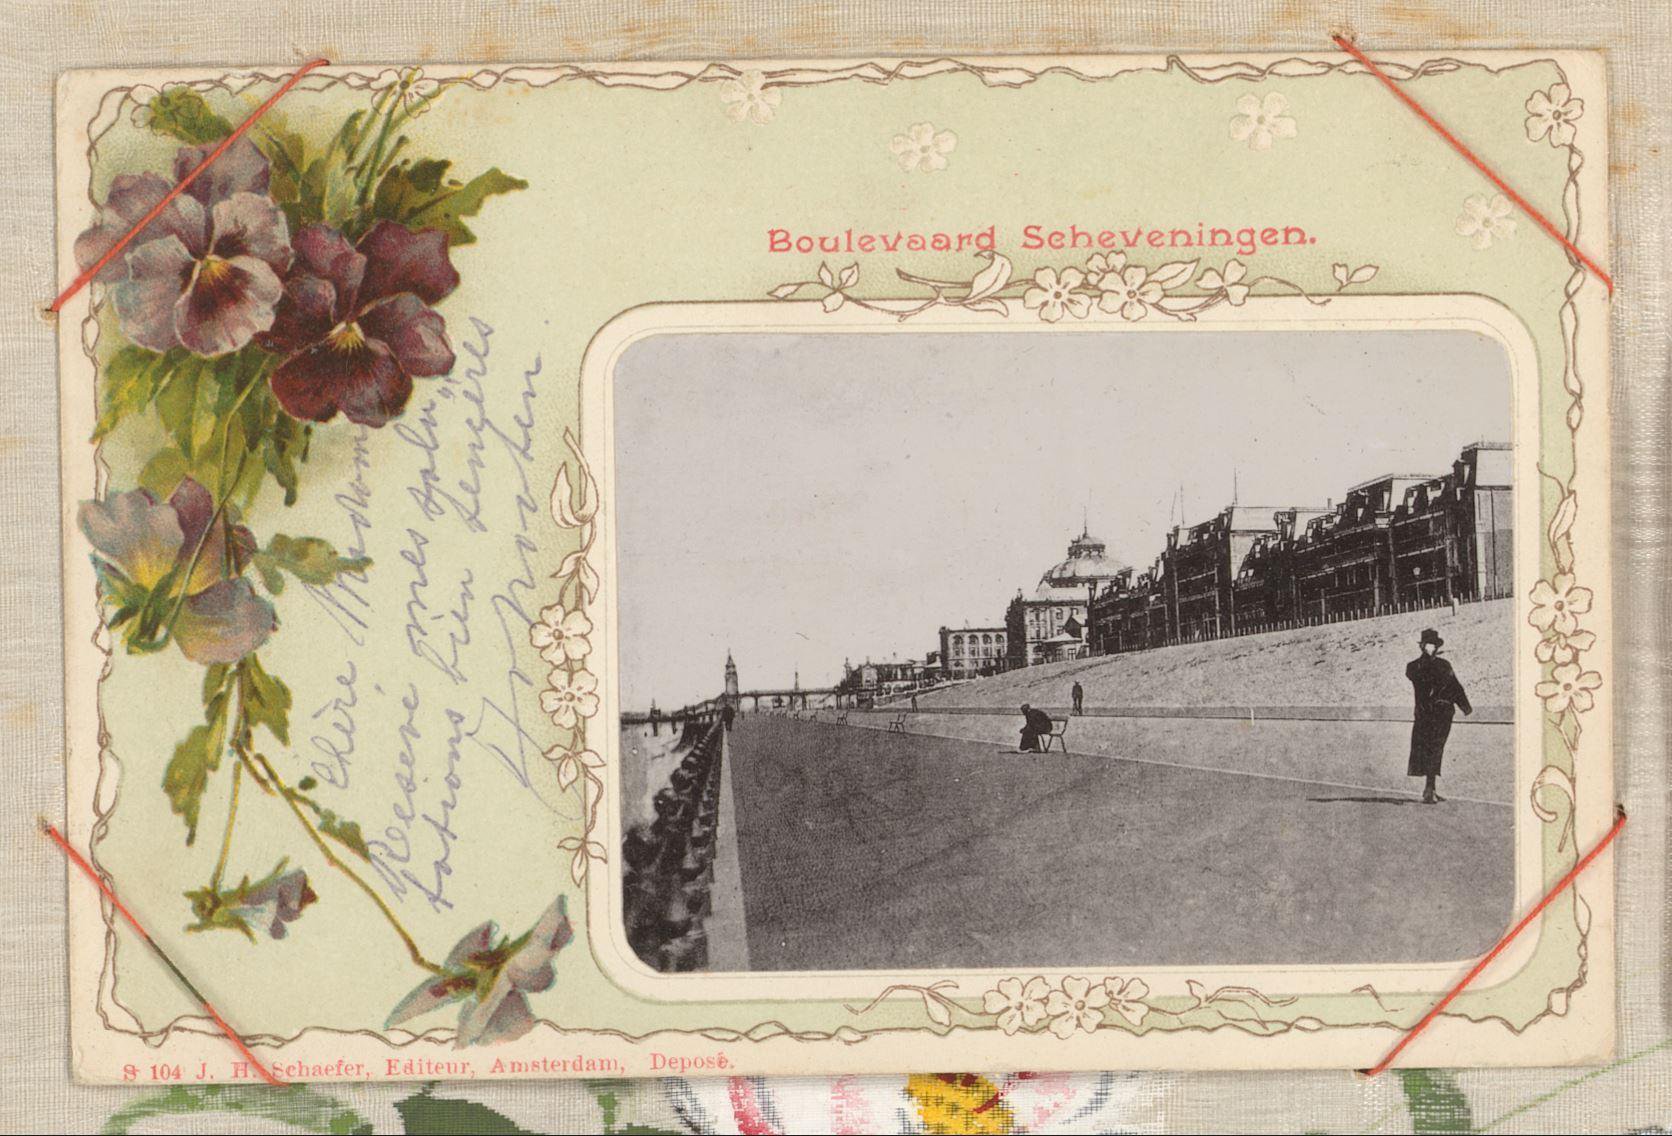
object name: album leaf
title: Boulevard van Scheveningen met het Kurhaus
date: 1880-1910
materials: cardboard, paint, paper, silk, textile, watercolor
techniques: brush, chromolithography, photograph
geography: scheveningen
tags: avenue, boulevard, promenade, esplanade, coast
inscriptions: annotation: ‘[...]’, inscription: ‘S. 104 J. H. Schaefer, Editeur, Amsterdam, Deposé’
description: Deze prent maakt deel uit van een album.